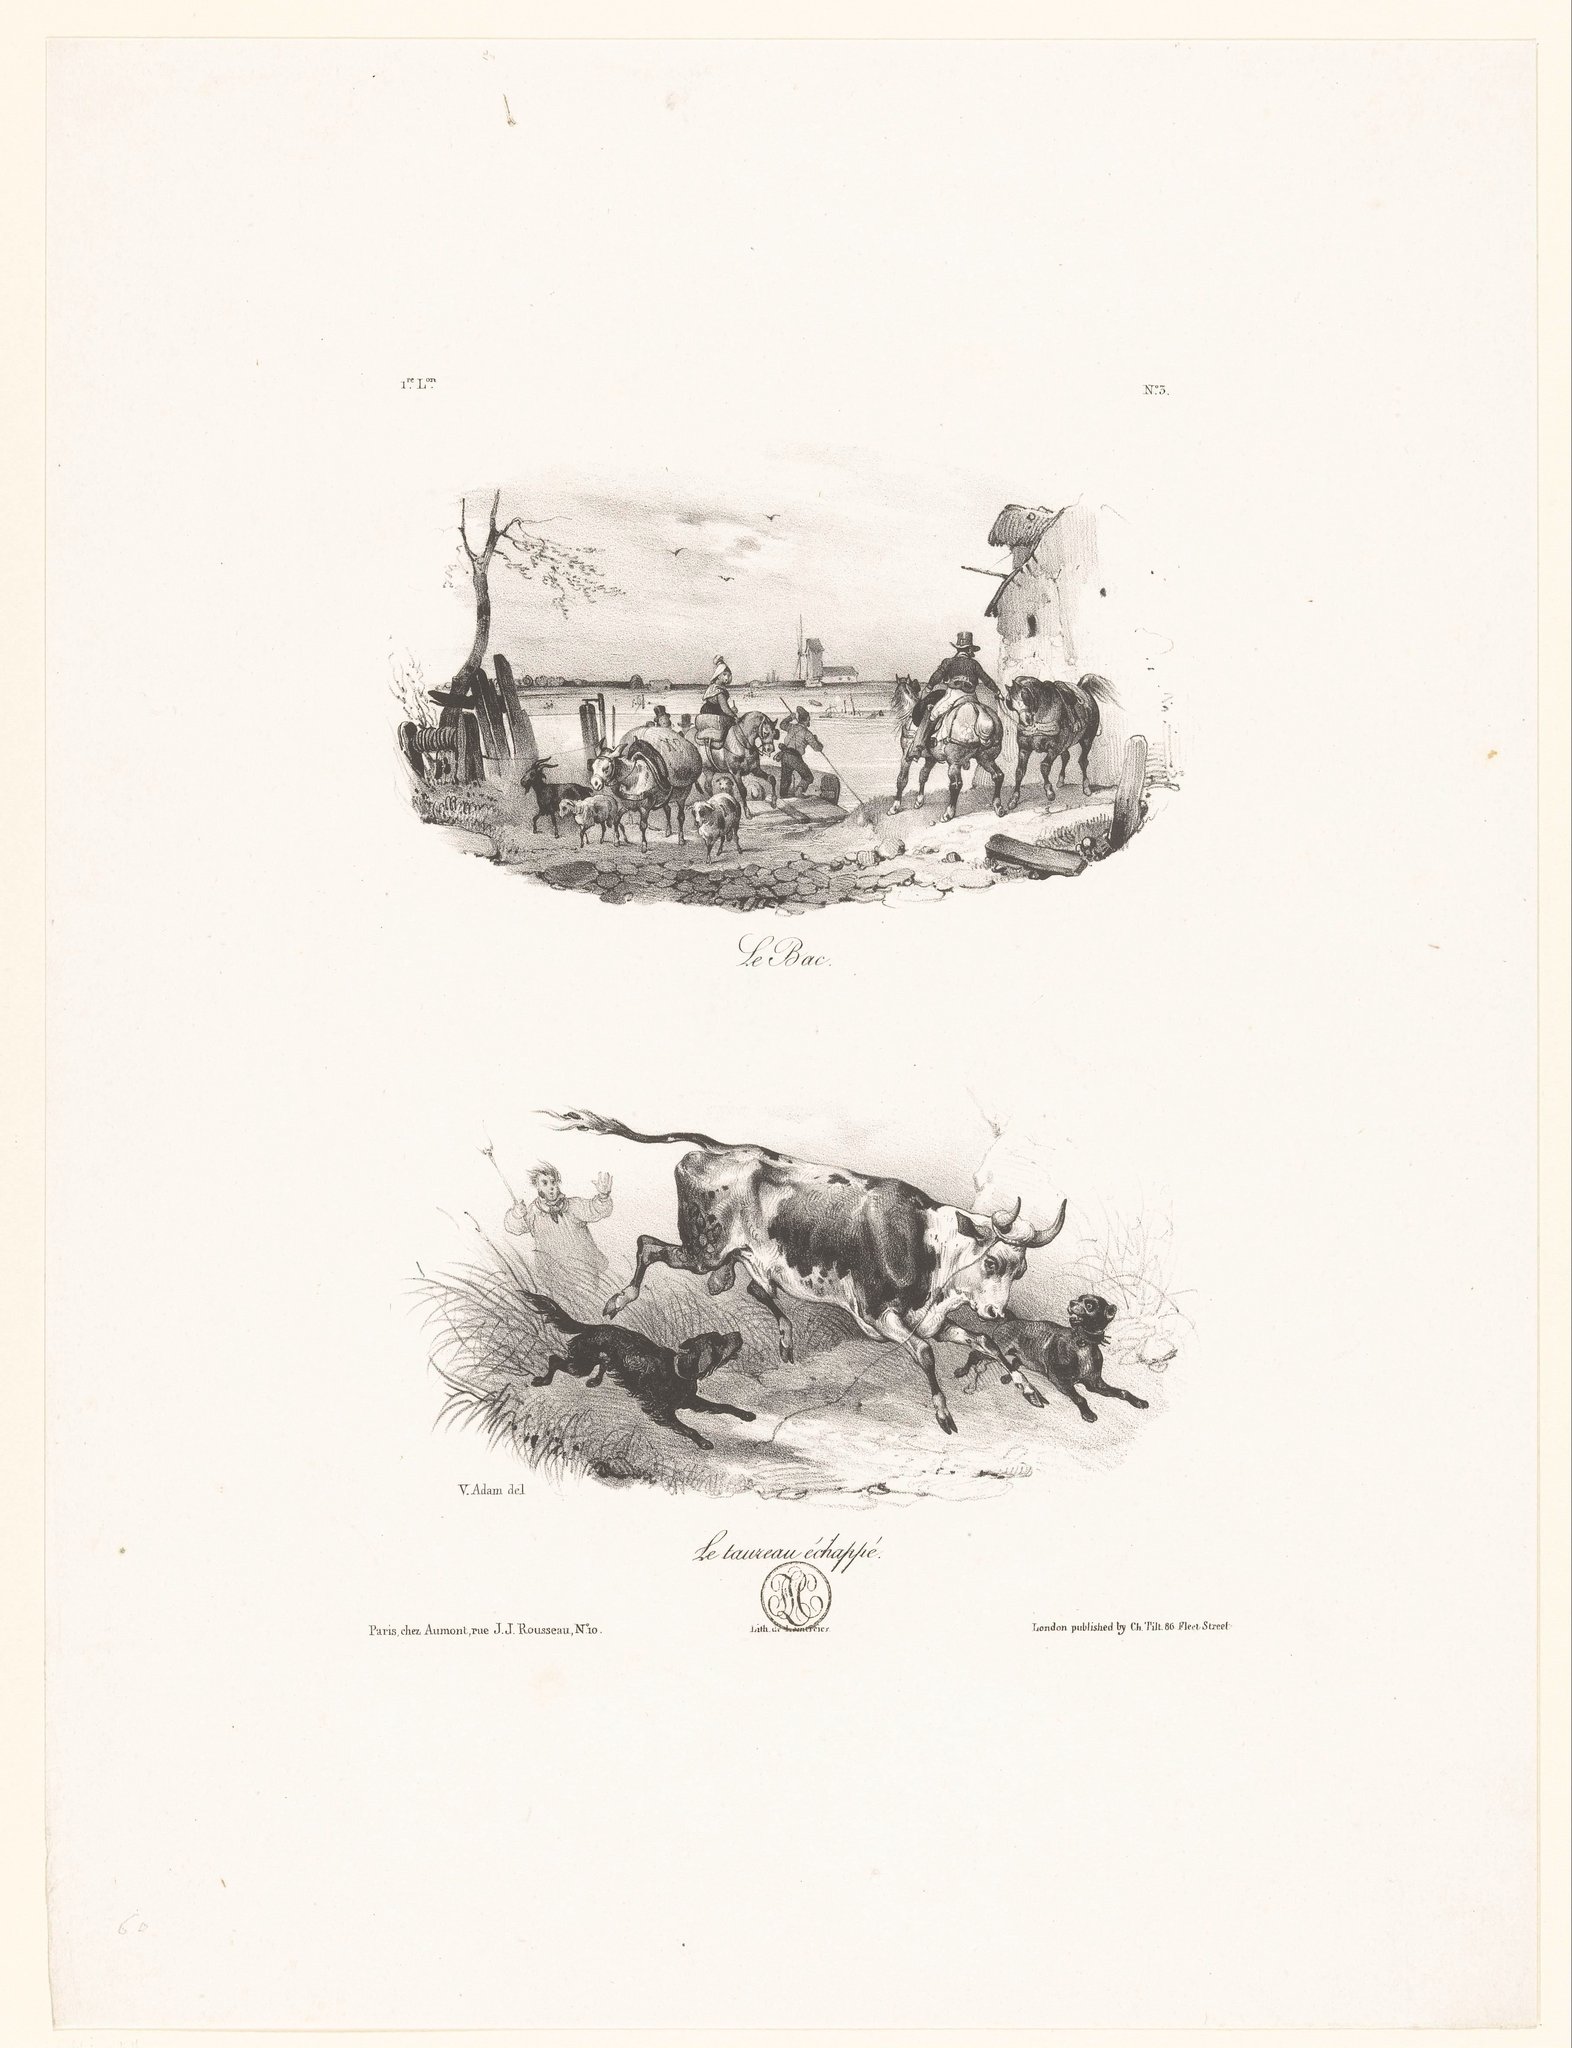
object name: print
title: Le Bac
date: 1828-1839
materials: paper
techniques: lithograph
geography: london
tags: bull, ferry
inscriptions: collector's mark: Lugt 3186, annotation: ‘60’, collector's mark: Lugt 2228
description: De veerman heeft zojuist aangemeerd. Een groep mensen en dieren verlaten de veerpont. Rechts leidt een ruiter een extra paard naar de aanlegsteiger. Eerste Livraison.